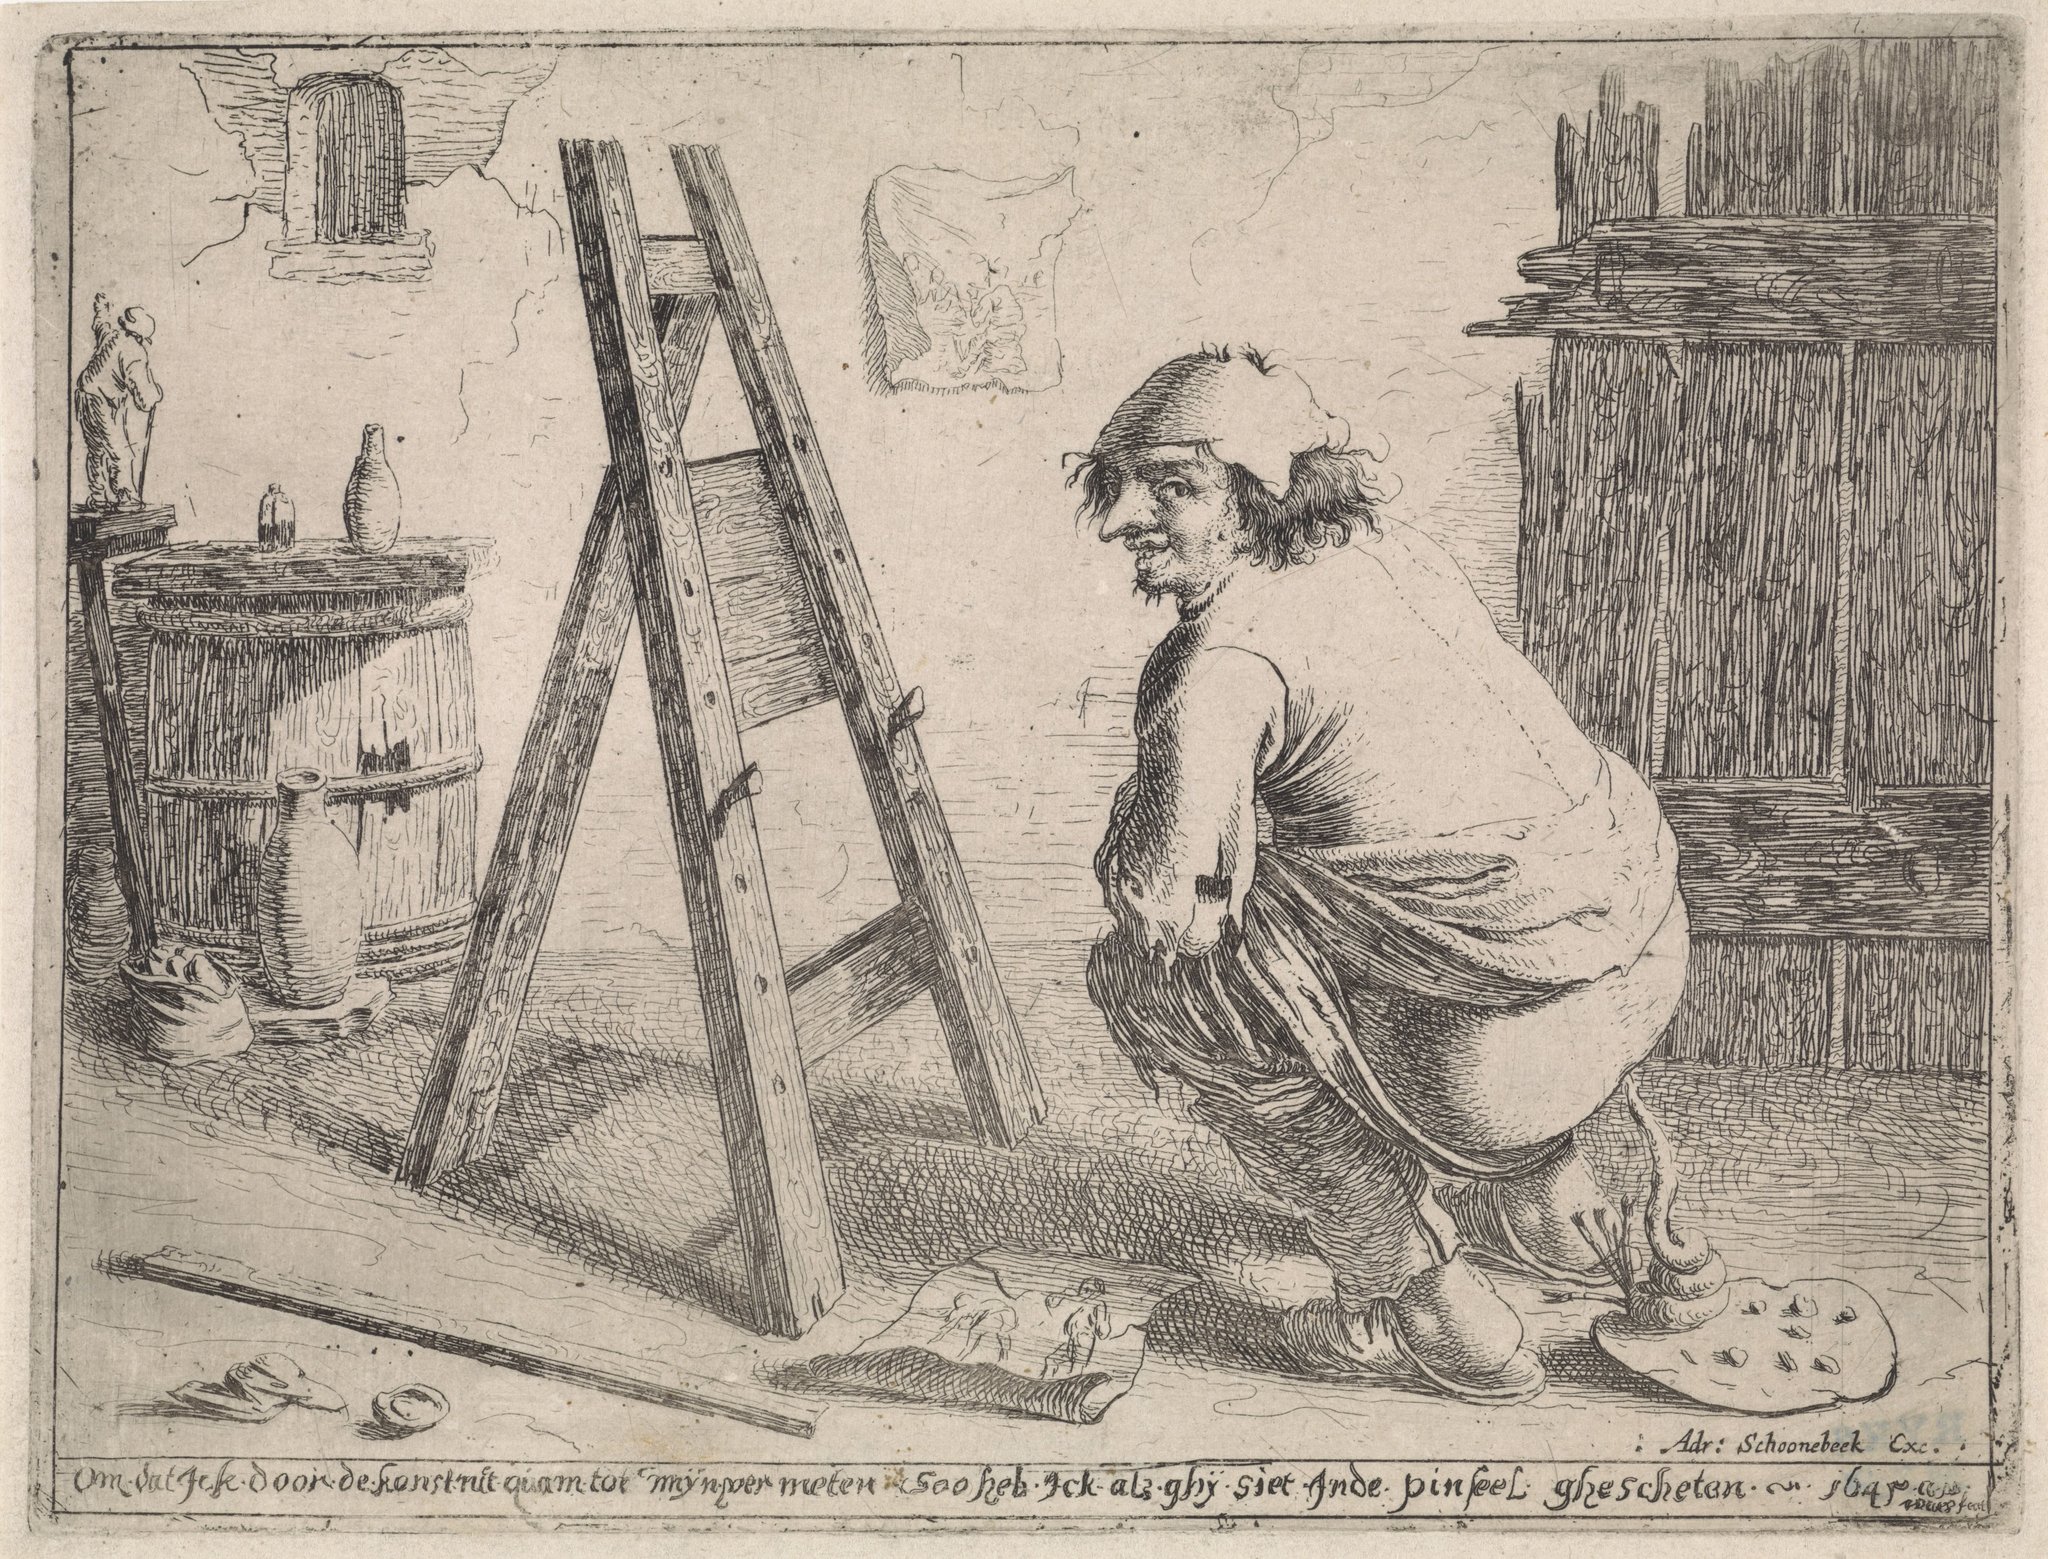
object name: print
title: De schijtende kunstenaar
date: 1645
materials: paper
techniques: etching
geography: gouda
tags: artist destroying his own work, defecation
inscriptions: collector's mark: Lugt 2165, collector's mark: Lugt 2612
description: Een kunstenaar zit in zijn atelier gehurkt voor zijn schildersezel en poept op zijn palet met verf en kwasten. Hij kijkt de beschouwer grinnikend aan. In de marge een verklarend onderschrift in het Nederlands: de schilderkunst heeft de kunstenaar niet gebracht waar hij op hoopte en daarom neemt hij 'wraak'.